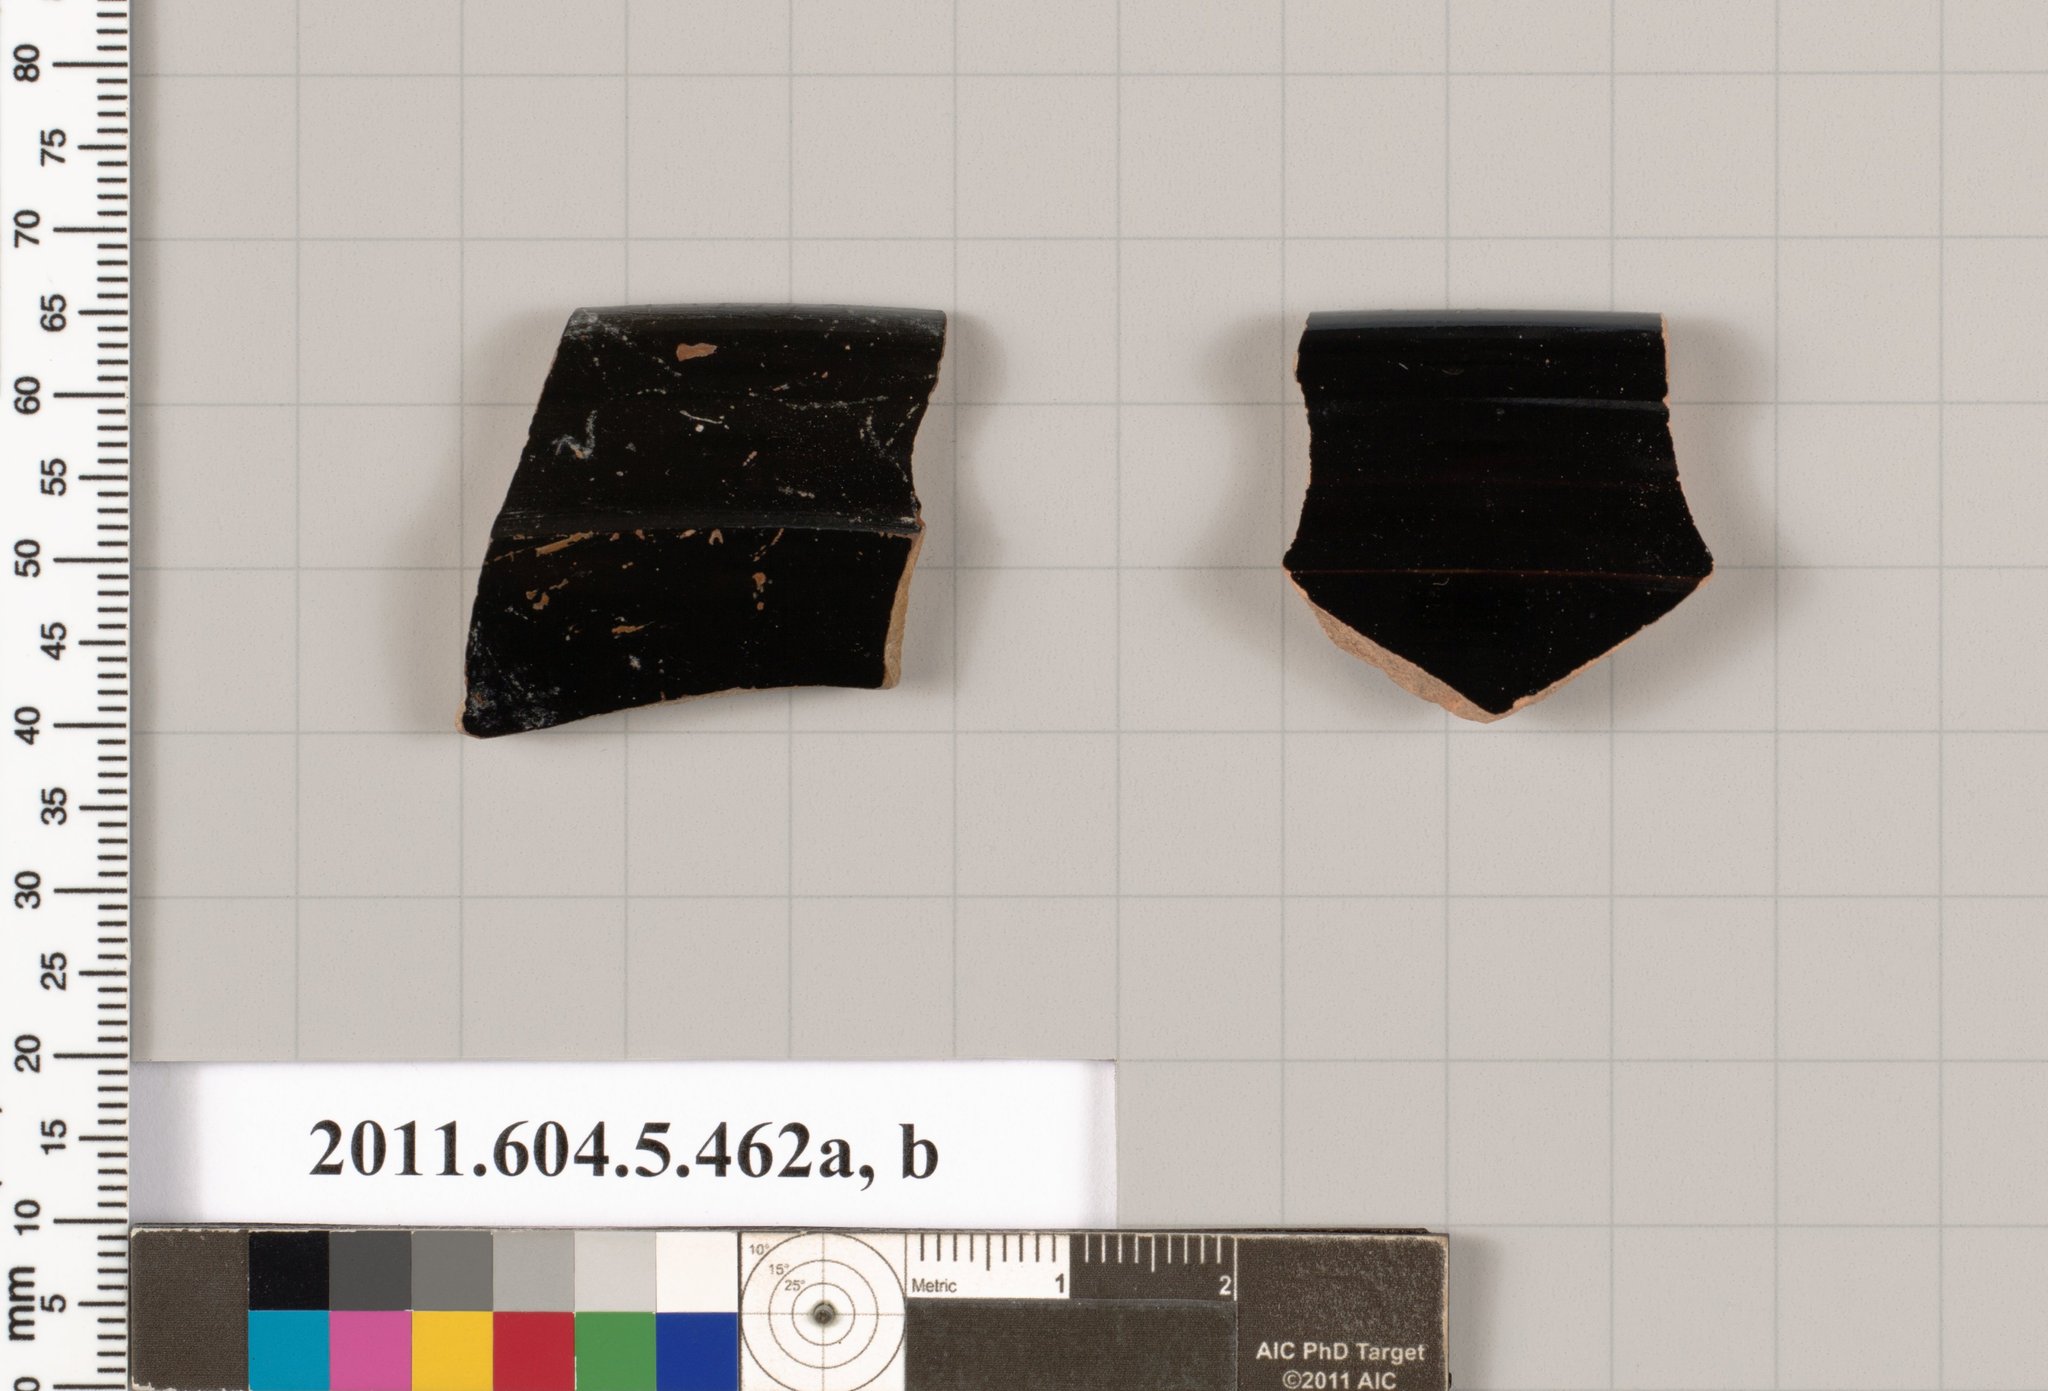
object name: kylix fragment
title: Terracotta rim fragments of kylikes (drinking cups)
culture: greek, attic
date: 600-401 BCE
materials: terracotta